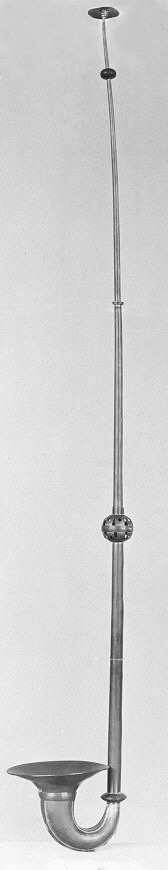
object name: zhajiao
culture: chinese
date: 1801-1900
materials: metal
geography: china